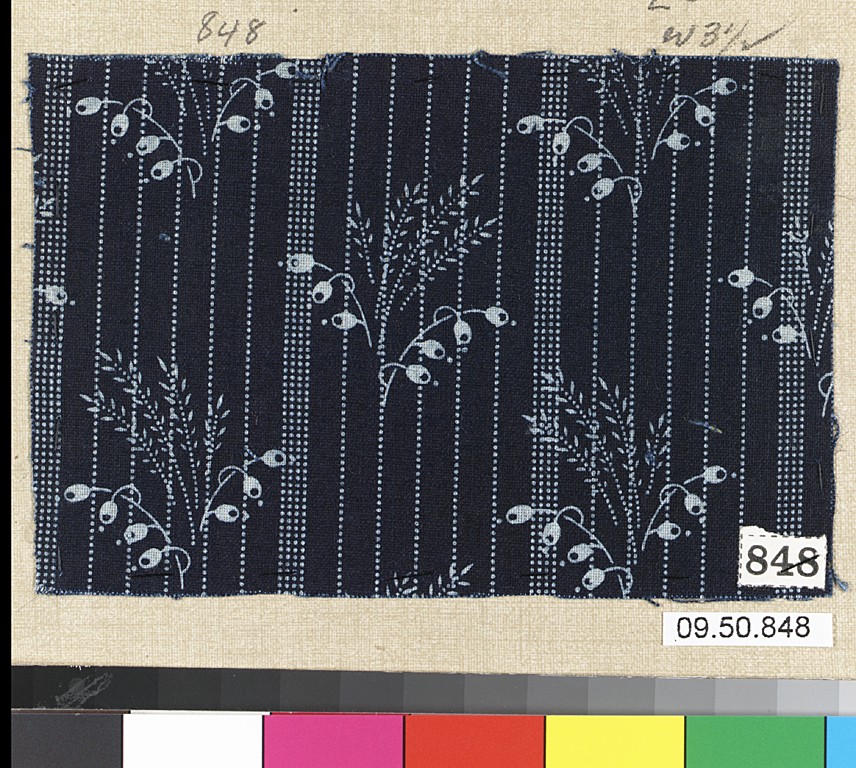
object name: piece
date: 1801-1900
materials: cotton